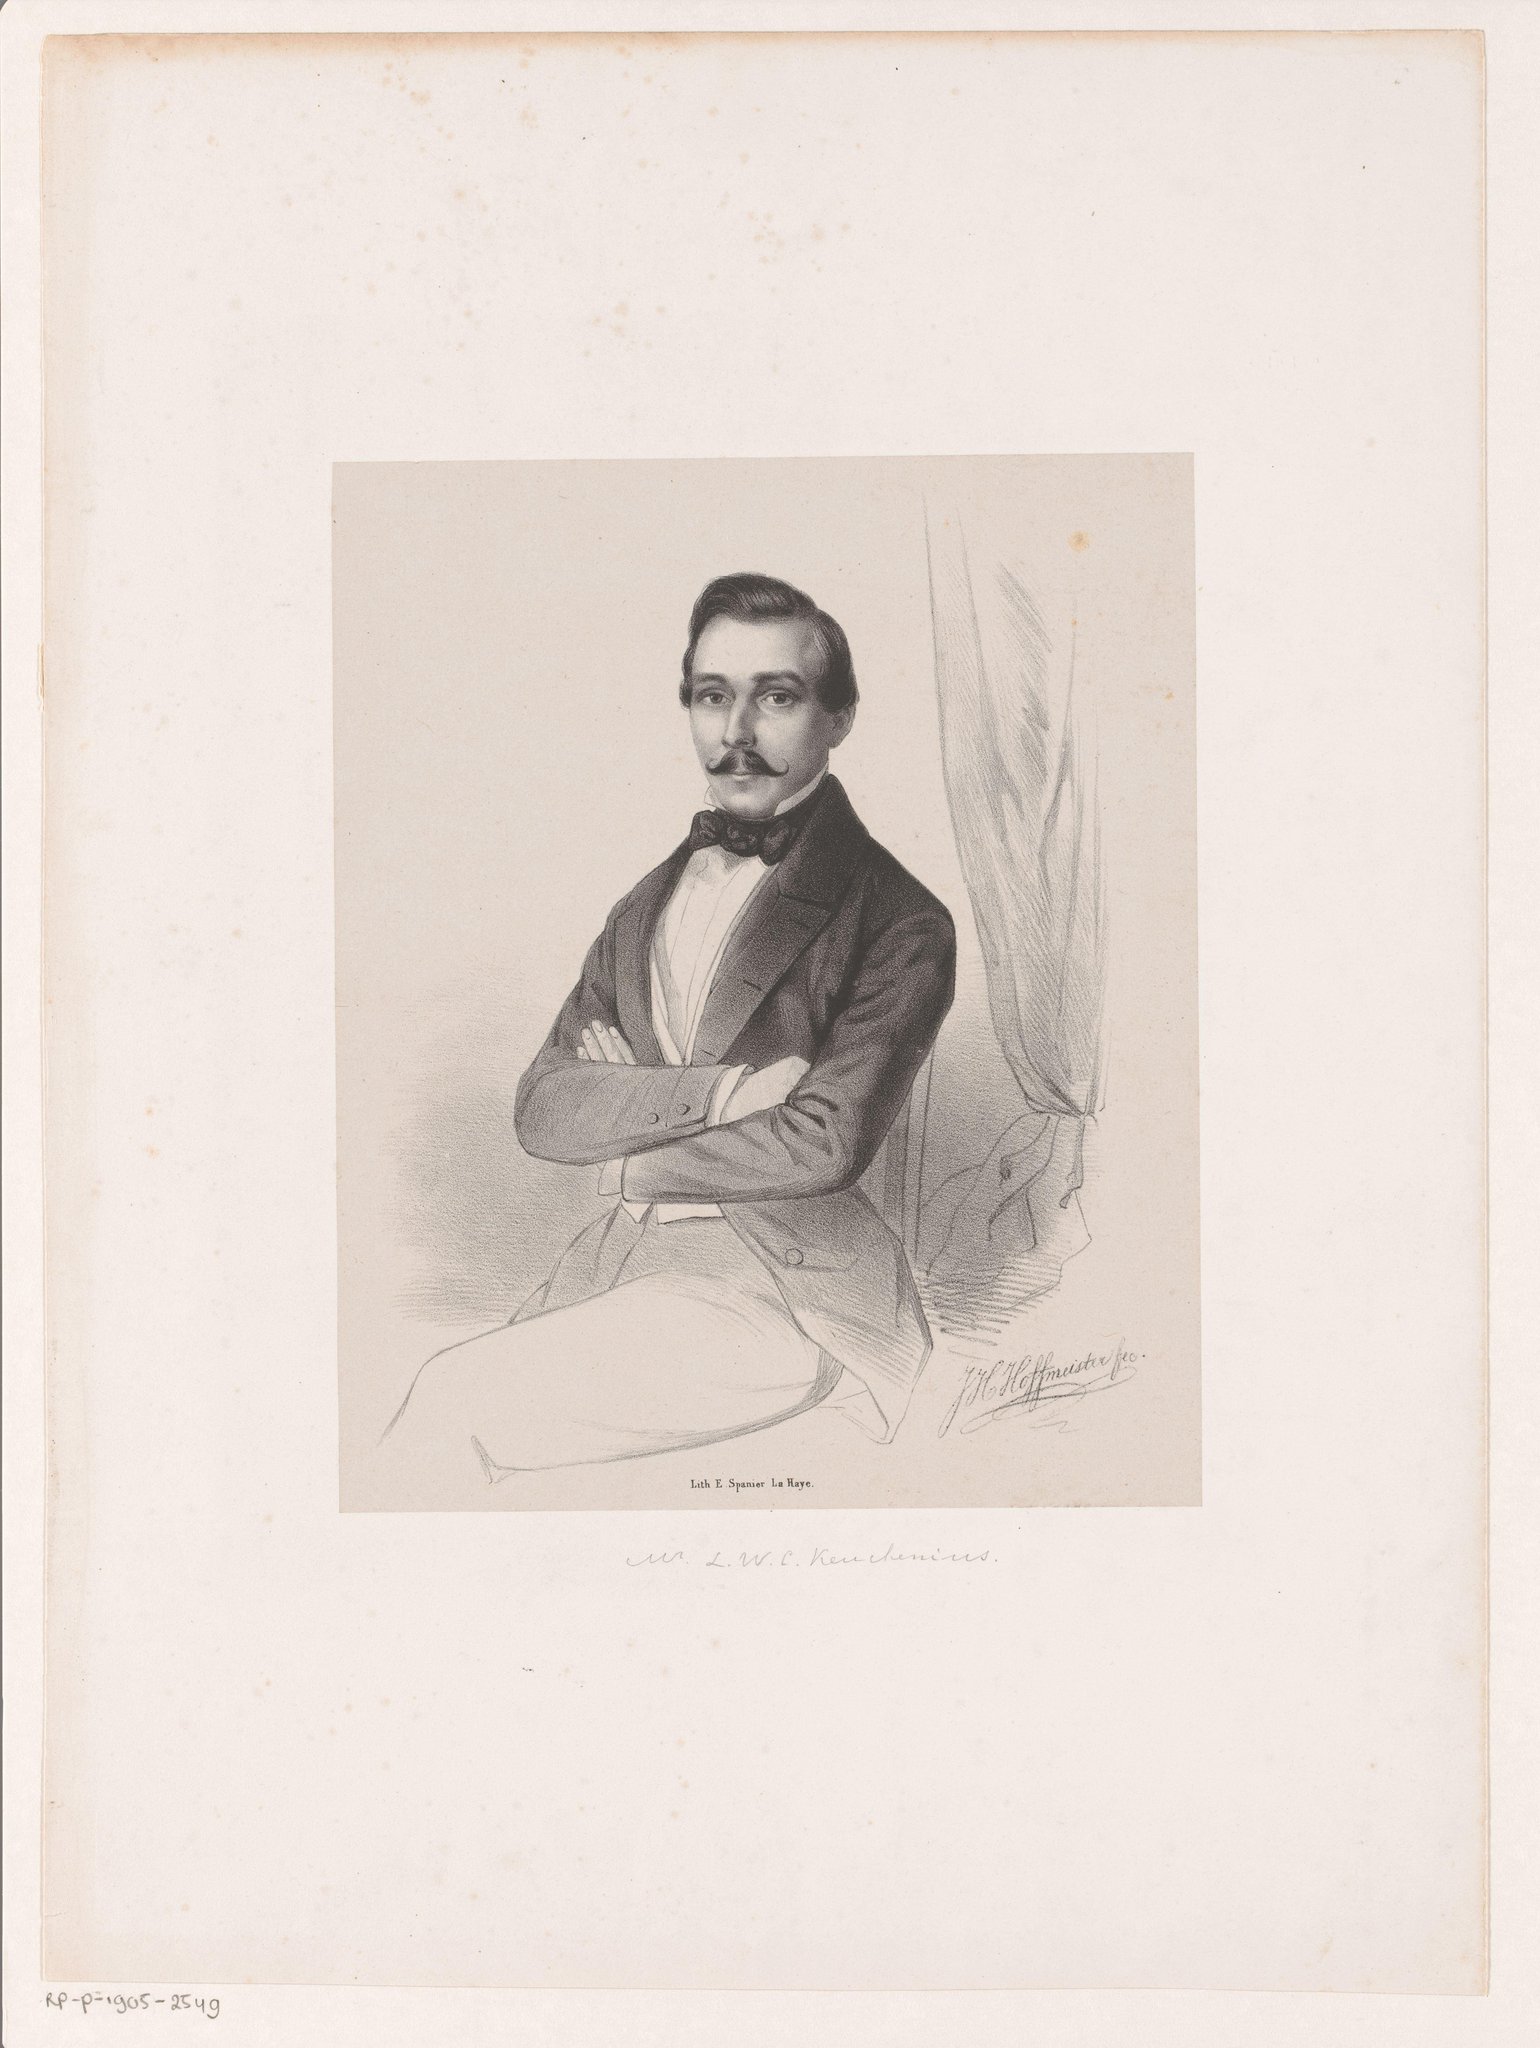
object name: print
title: Portret van Levinus Wilhelmus Christiaan Keuchenius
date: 1852-1891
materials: paper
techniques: lithograph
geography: netherlands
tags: arms crossed, historical persons (+ three-quarter length portrait)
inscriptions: collector's mark: Lugt 2228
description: De geportretteerde zit met gekruiste armen.